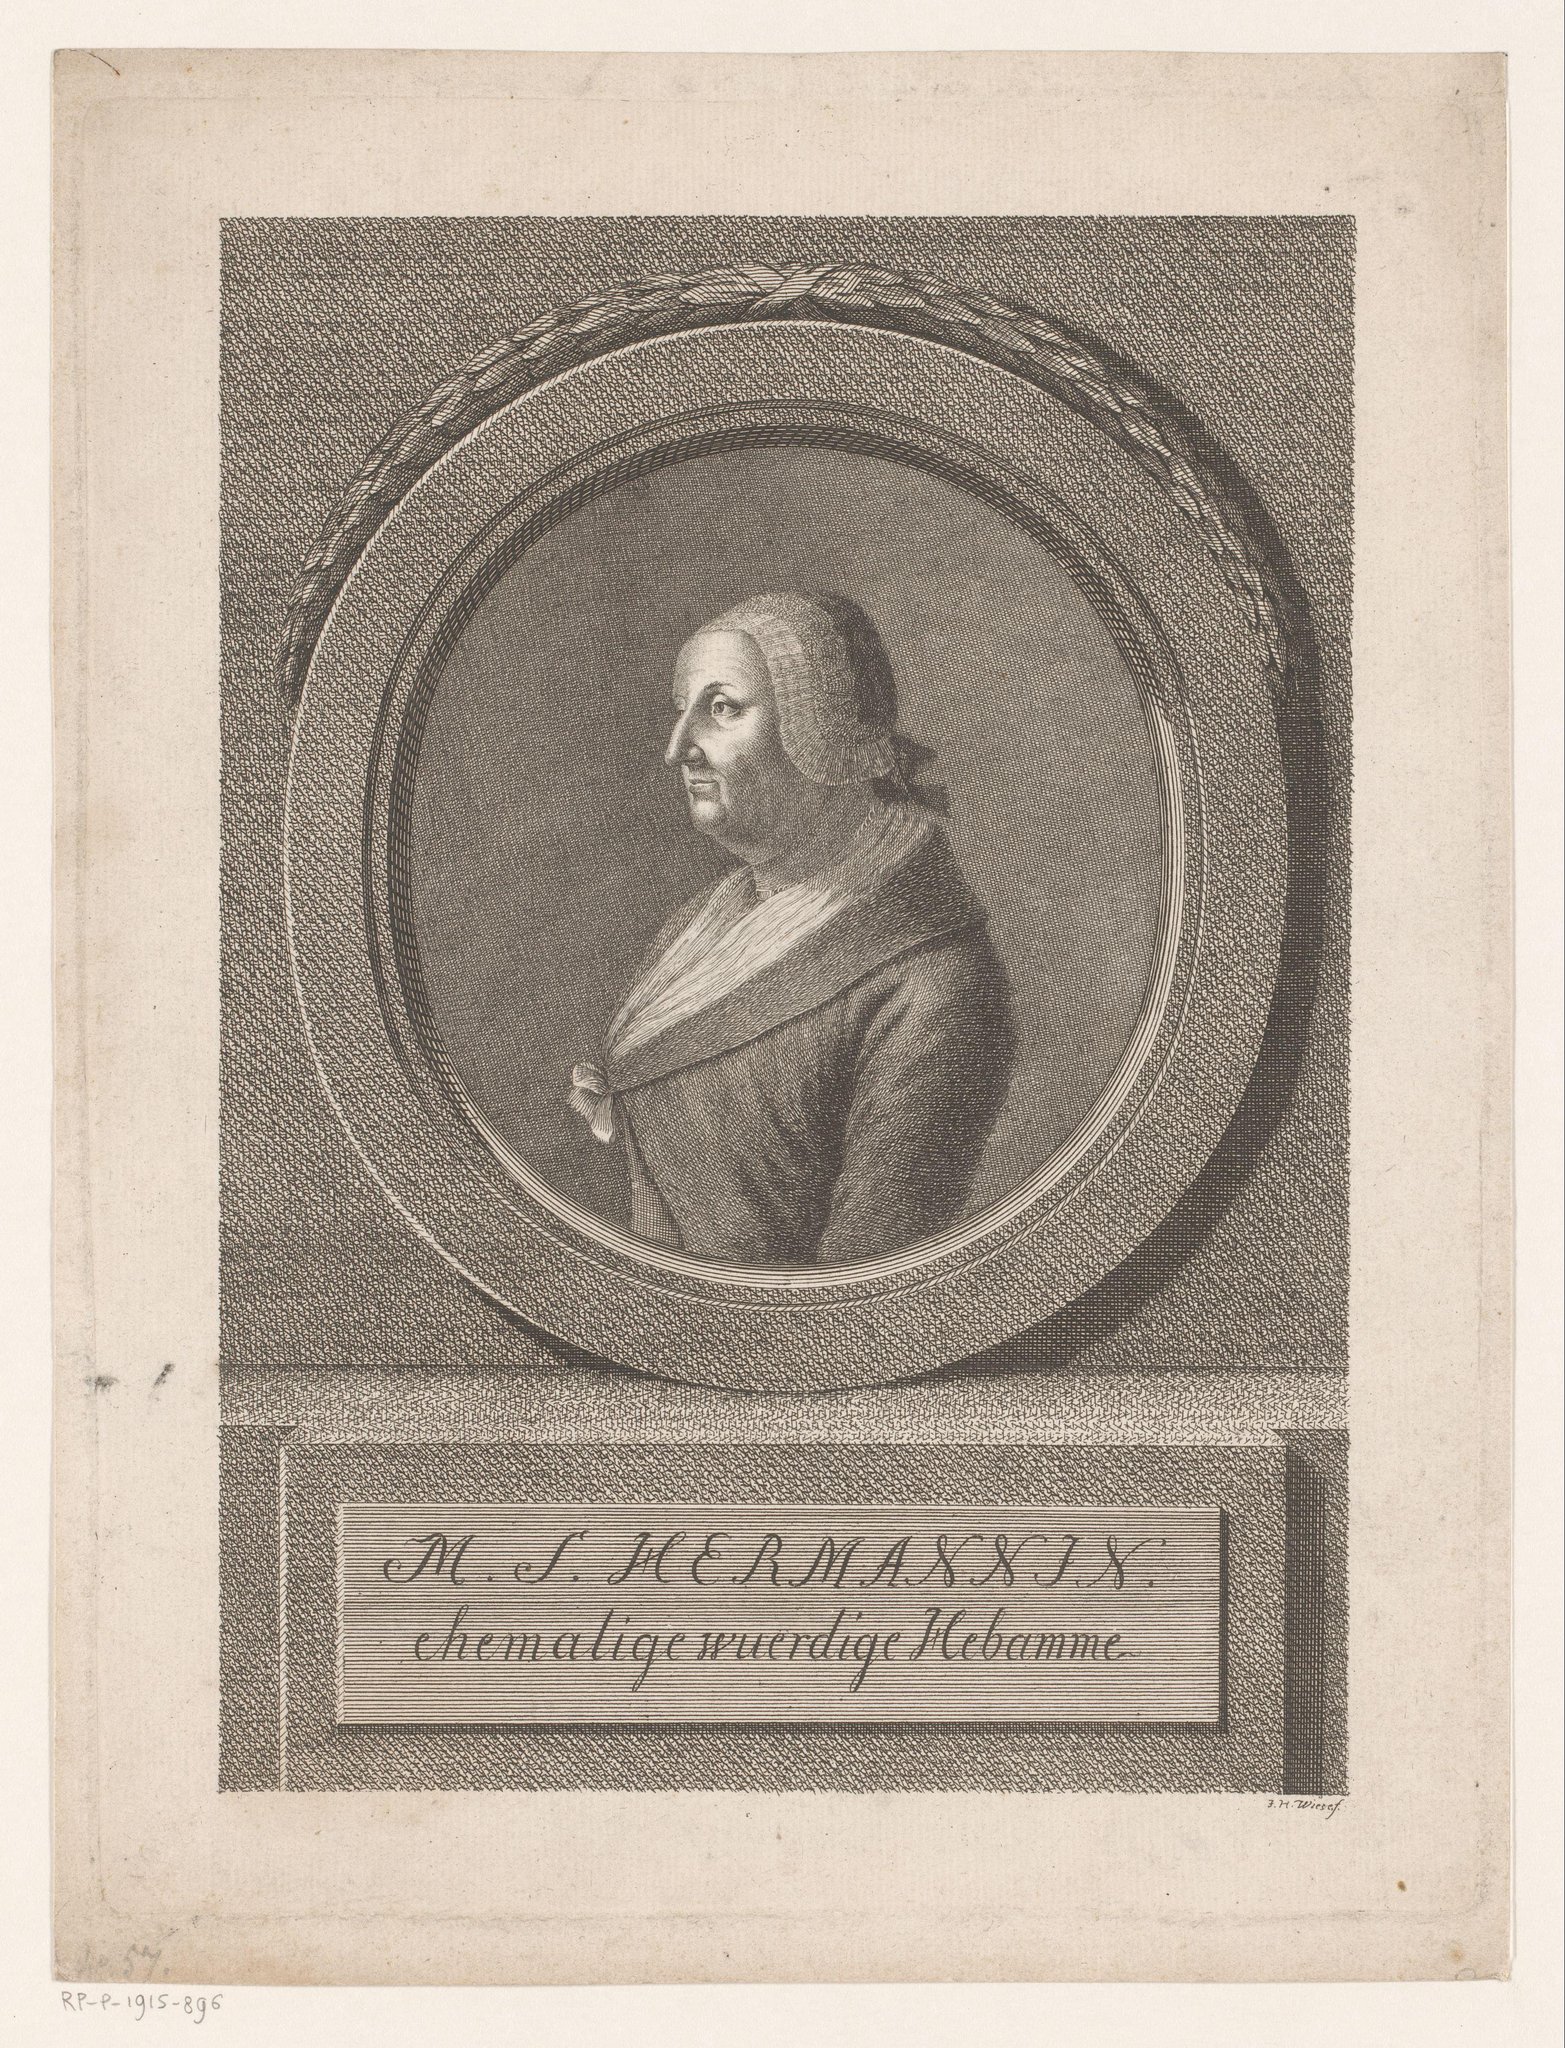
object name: print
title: Portret van M.S. Hermann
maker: johann heinrich wiese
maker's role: painter, print maker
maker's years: 1748-1803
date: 1758-1803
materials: paper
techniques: etching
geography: germany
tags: historical persons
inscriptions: collector's mark: Lugt 2228